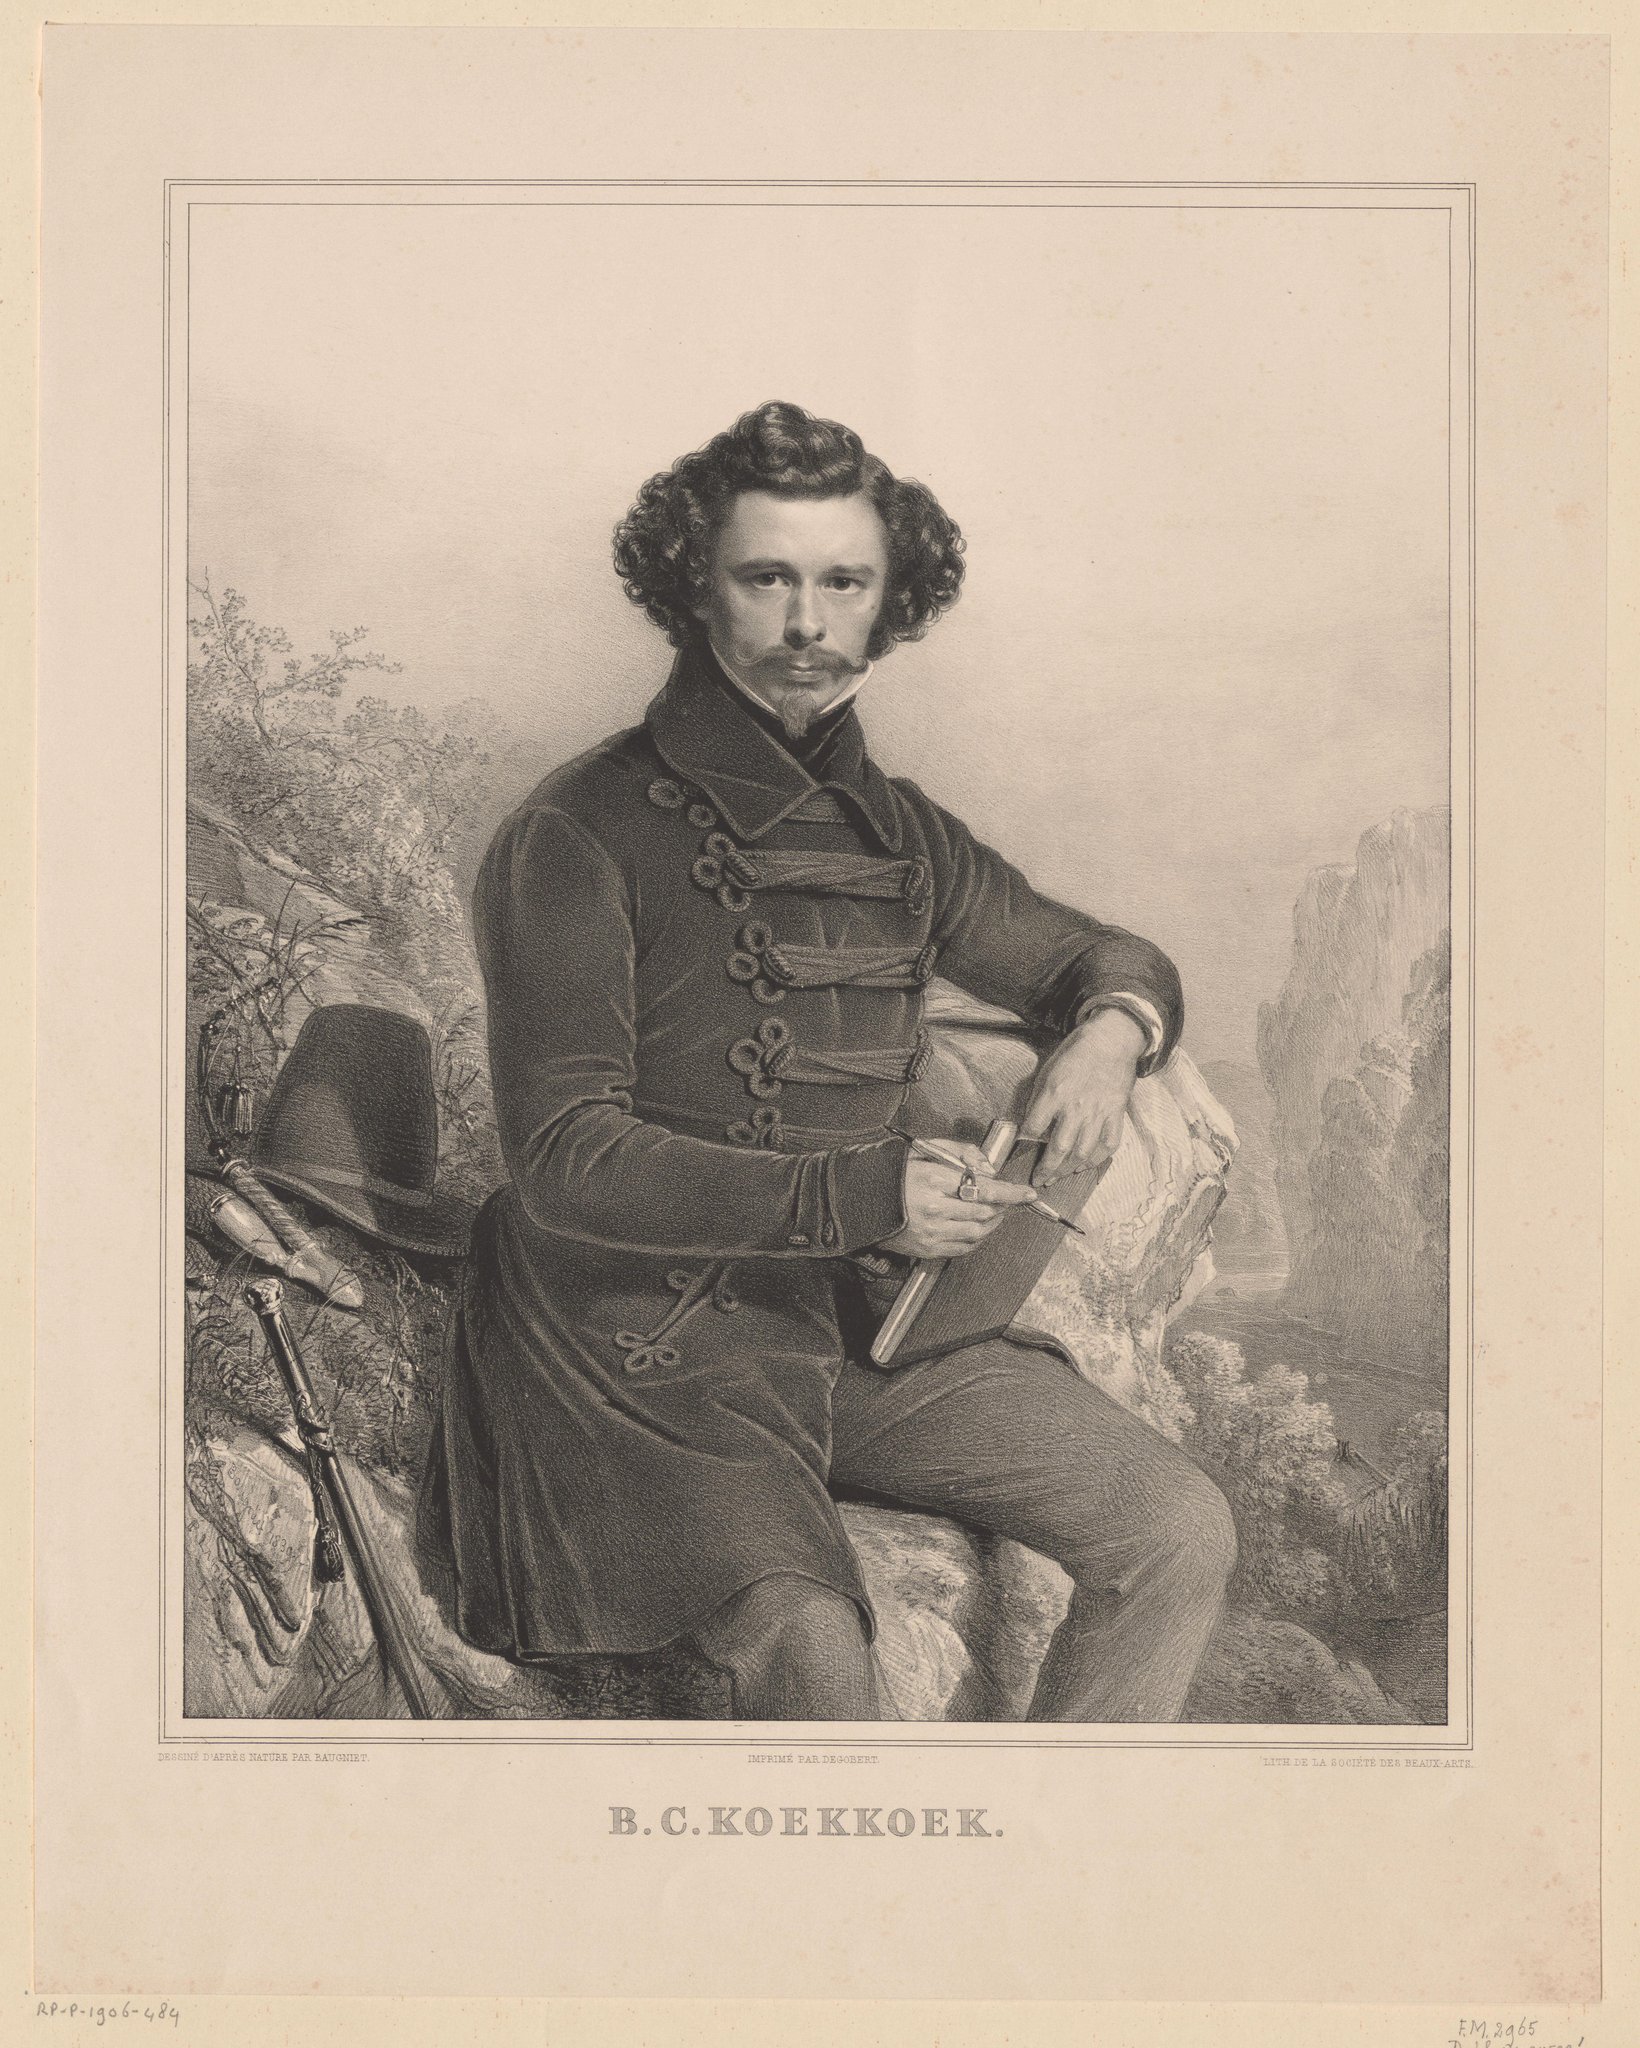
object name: print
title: Portret van Barend Cornelis Koekkoek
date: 1839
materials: paper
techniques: lithograph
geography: brussels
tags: middelburg, cleves, painter, print maker, draughtsman, barend cornelis koekkoek, landscapes, historical persons, portrait, self-portrait of painter, tools, implements of painter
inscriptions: collector's mark: Lugt 2228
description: Prent waarschijnlijk uit: Baugniet, Charles. Les artistes contemporains: portraits lithographiés d'après nature, accompagnés de notices sur la vie et les ouvrages de chacun d'eux. Brussel: De Wasme-Pletinckx, [1836-1840].